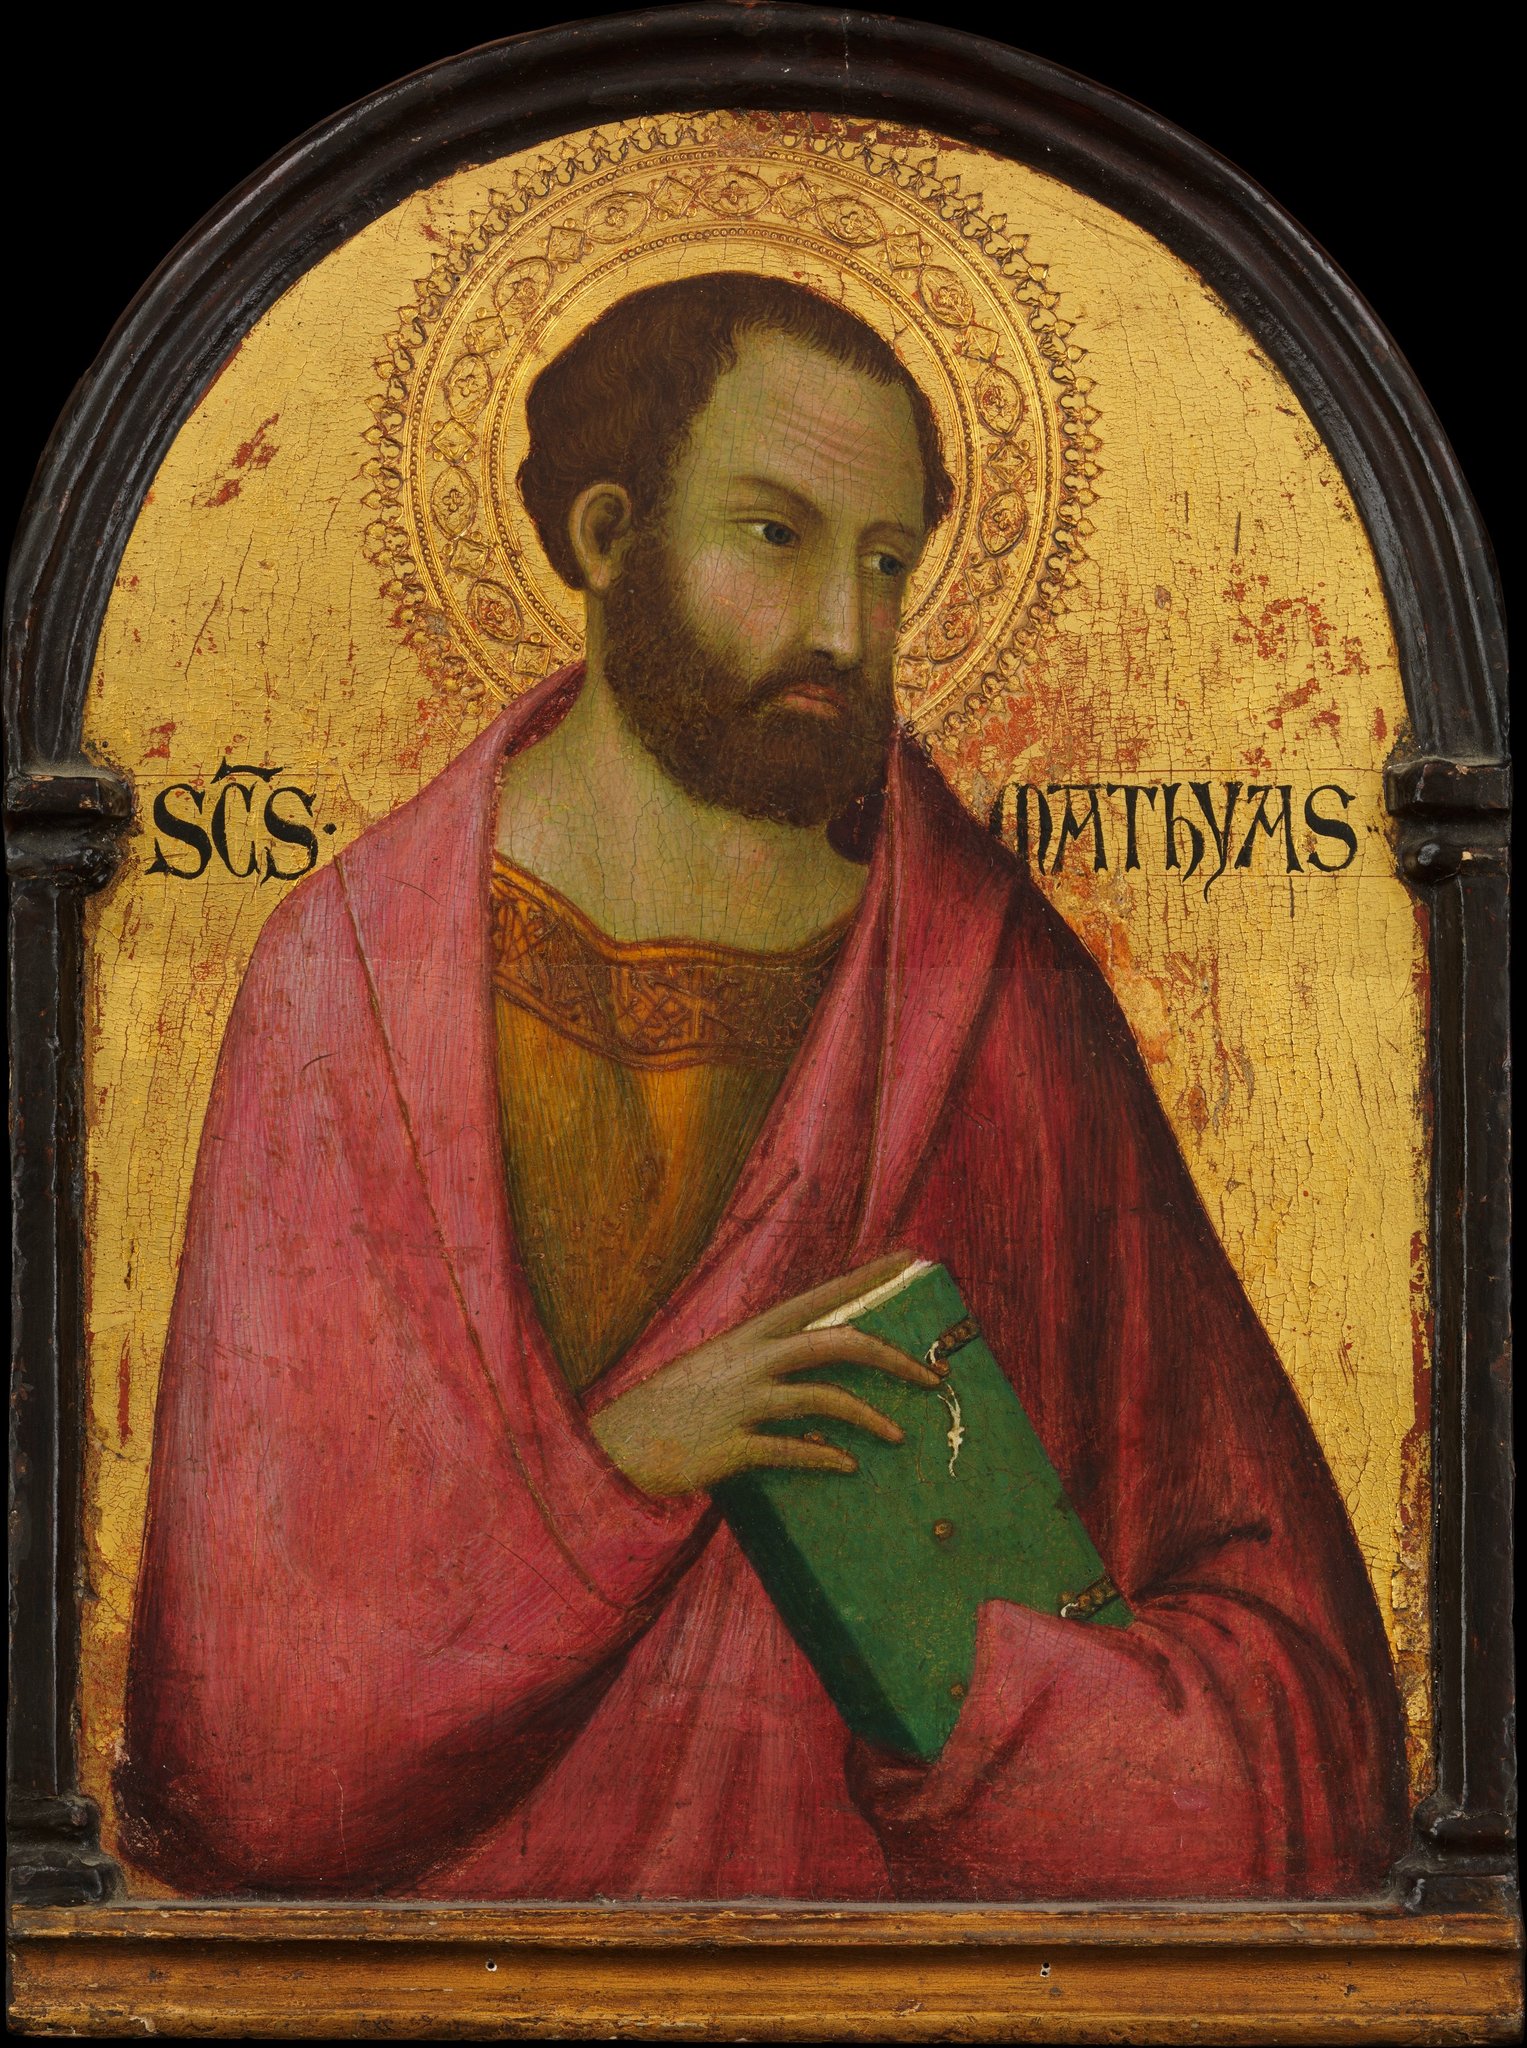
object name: painting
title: Saint Matthias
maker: simone martini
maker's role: artist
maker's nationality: italian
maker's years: 1315-1344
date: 1317-1319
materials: gold leaf, paint, wood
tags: books,men,saints